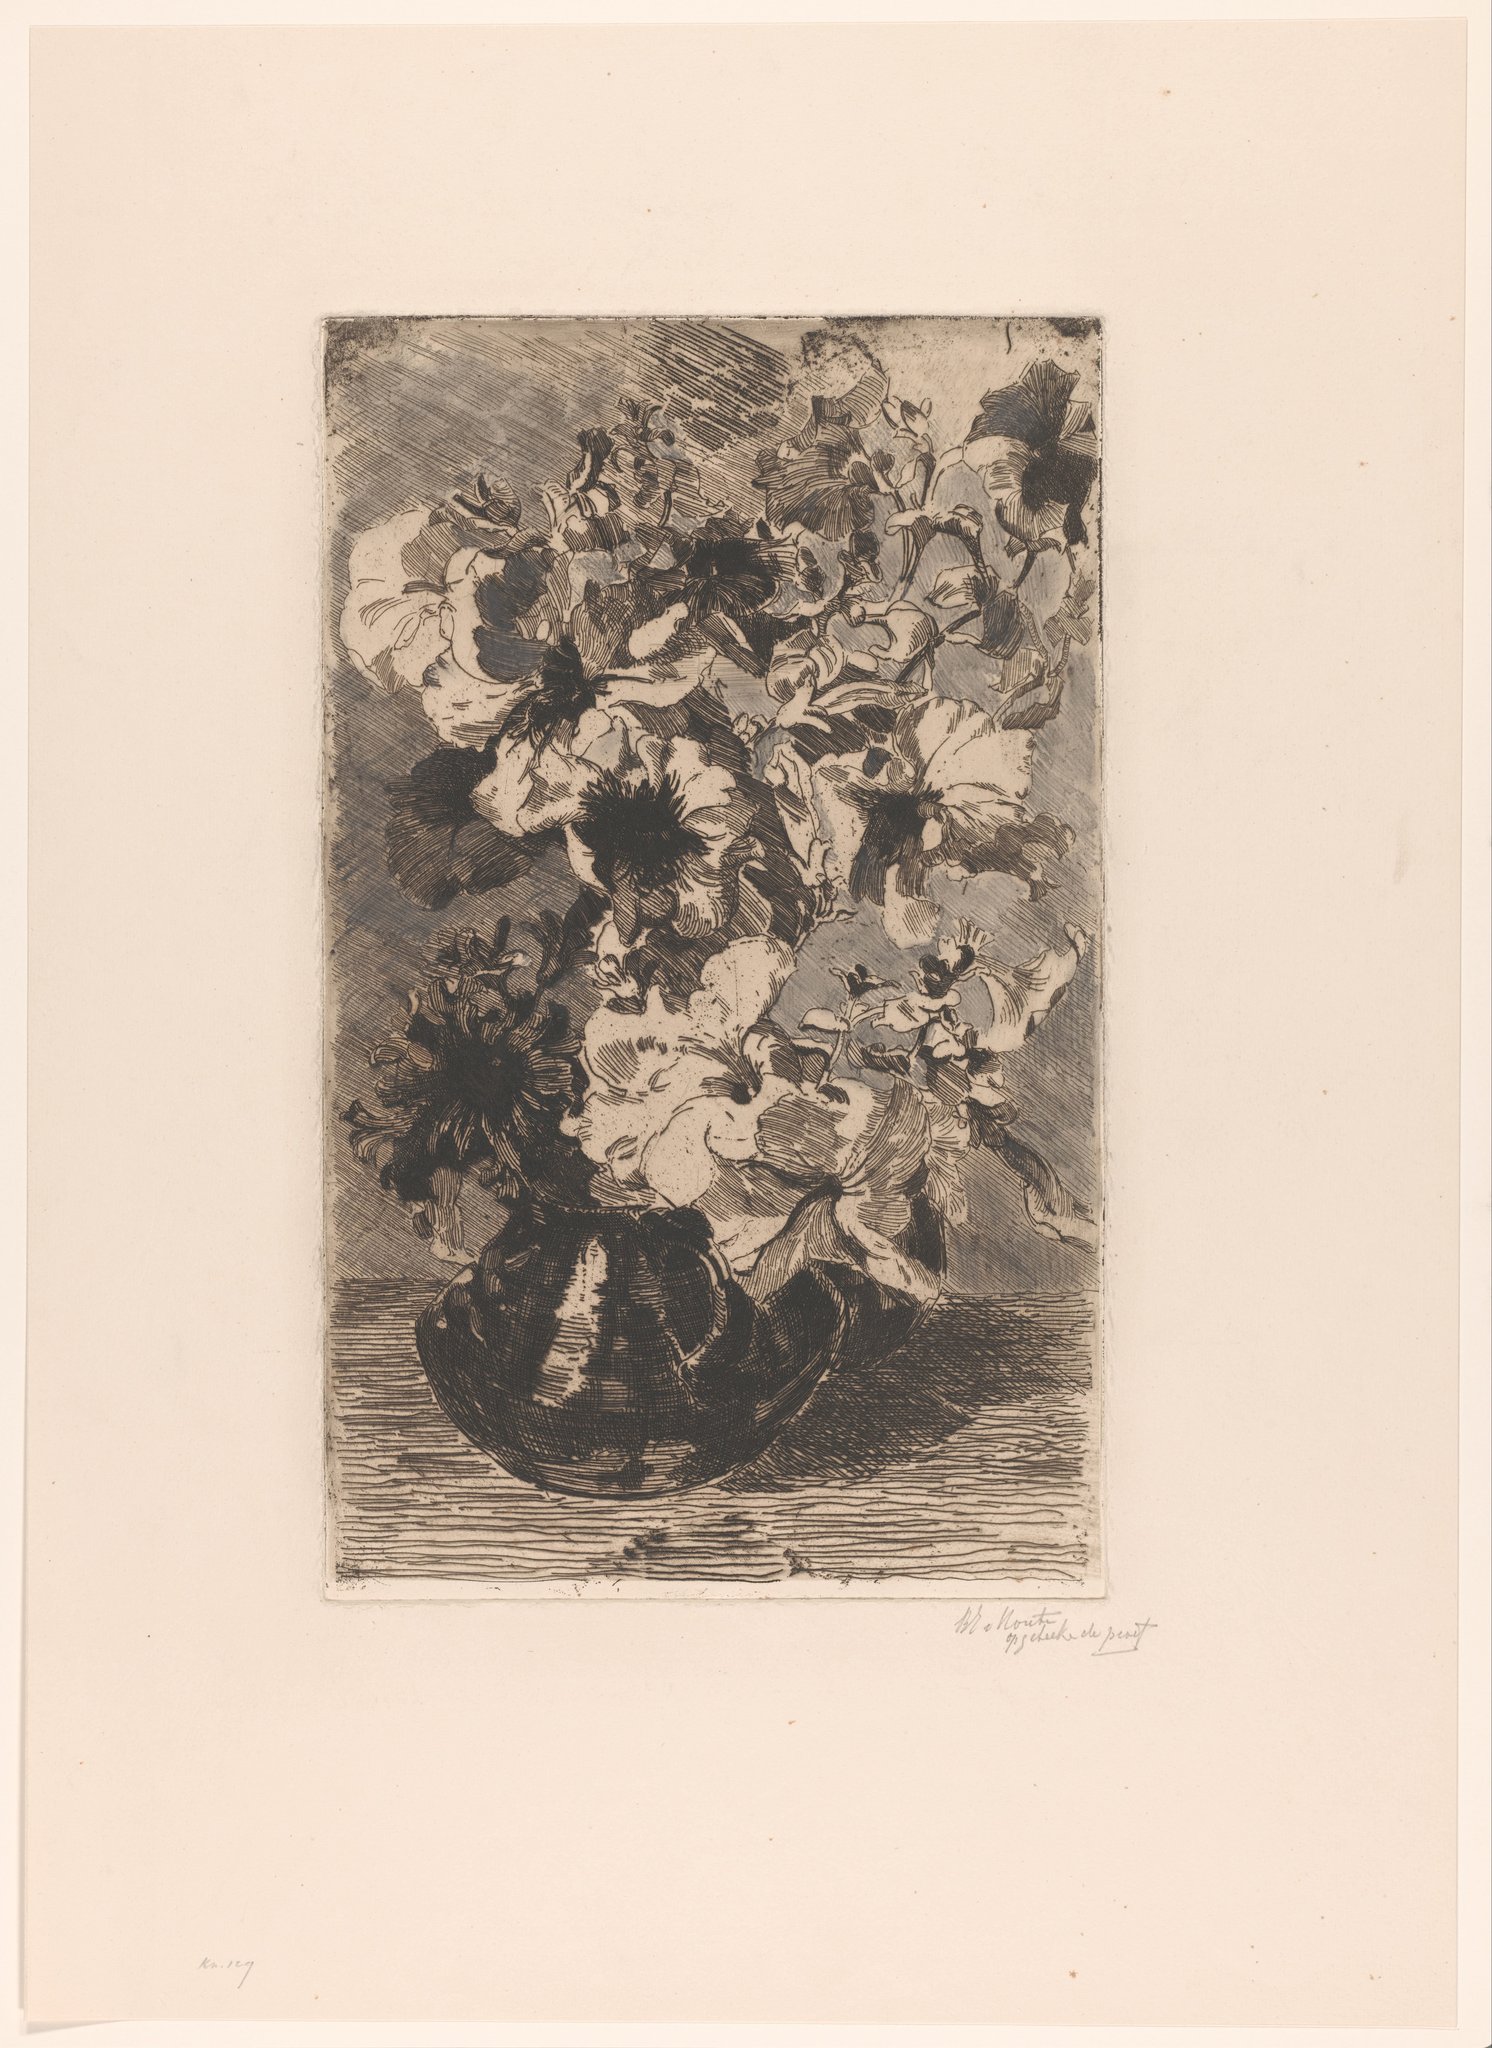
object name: print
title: Petunia's in kan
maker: barbara elisabeth van houten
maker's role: draughtsman, print maker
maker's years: 1862-1950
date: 1872-1950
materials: paper, pencil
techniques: etching, intaglio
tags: flowers: petunia, flowers in a vase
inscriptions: collector's mark: Lugt 2228, inscription: ‘opgeteekende proef’